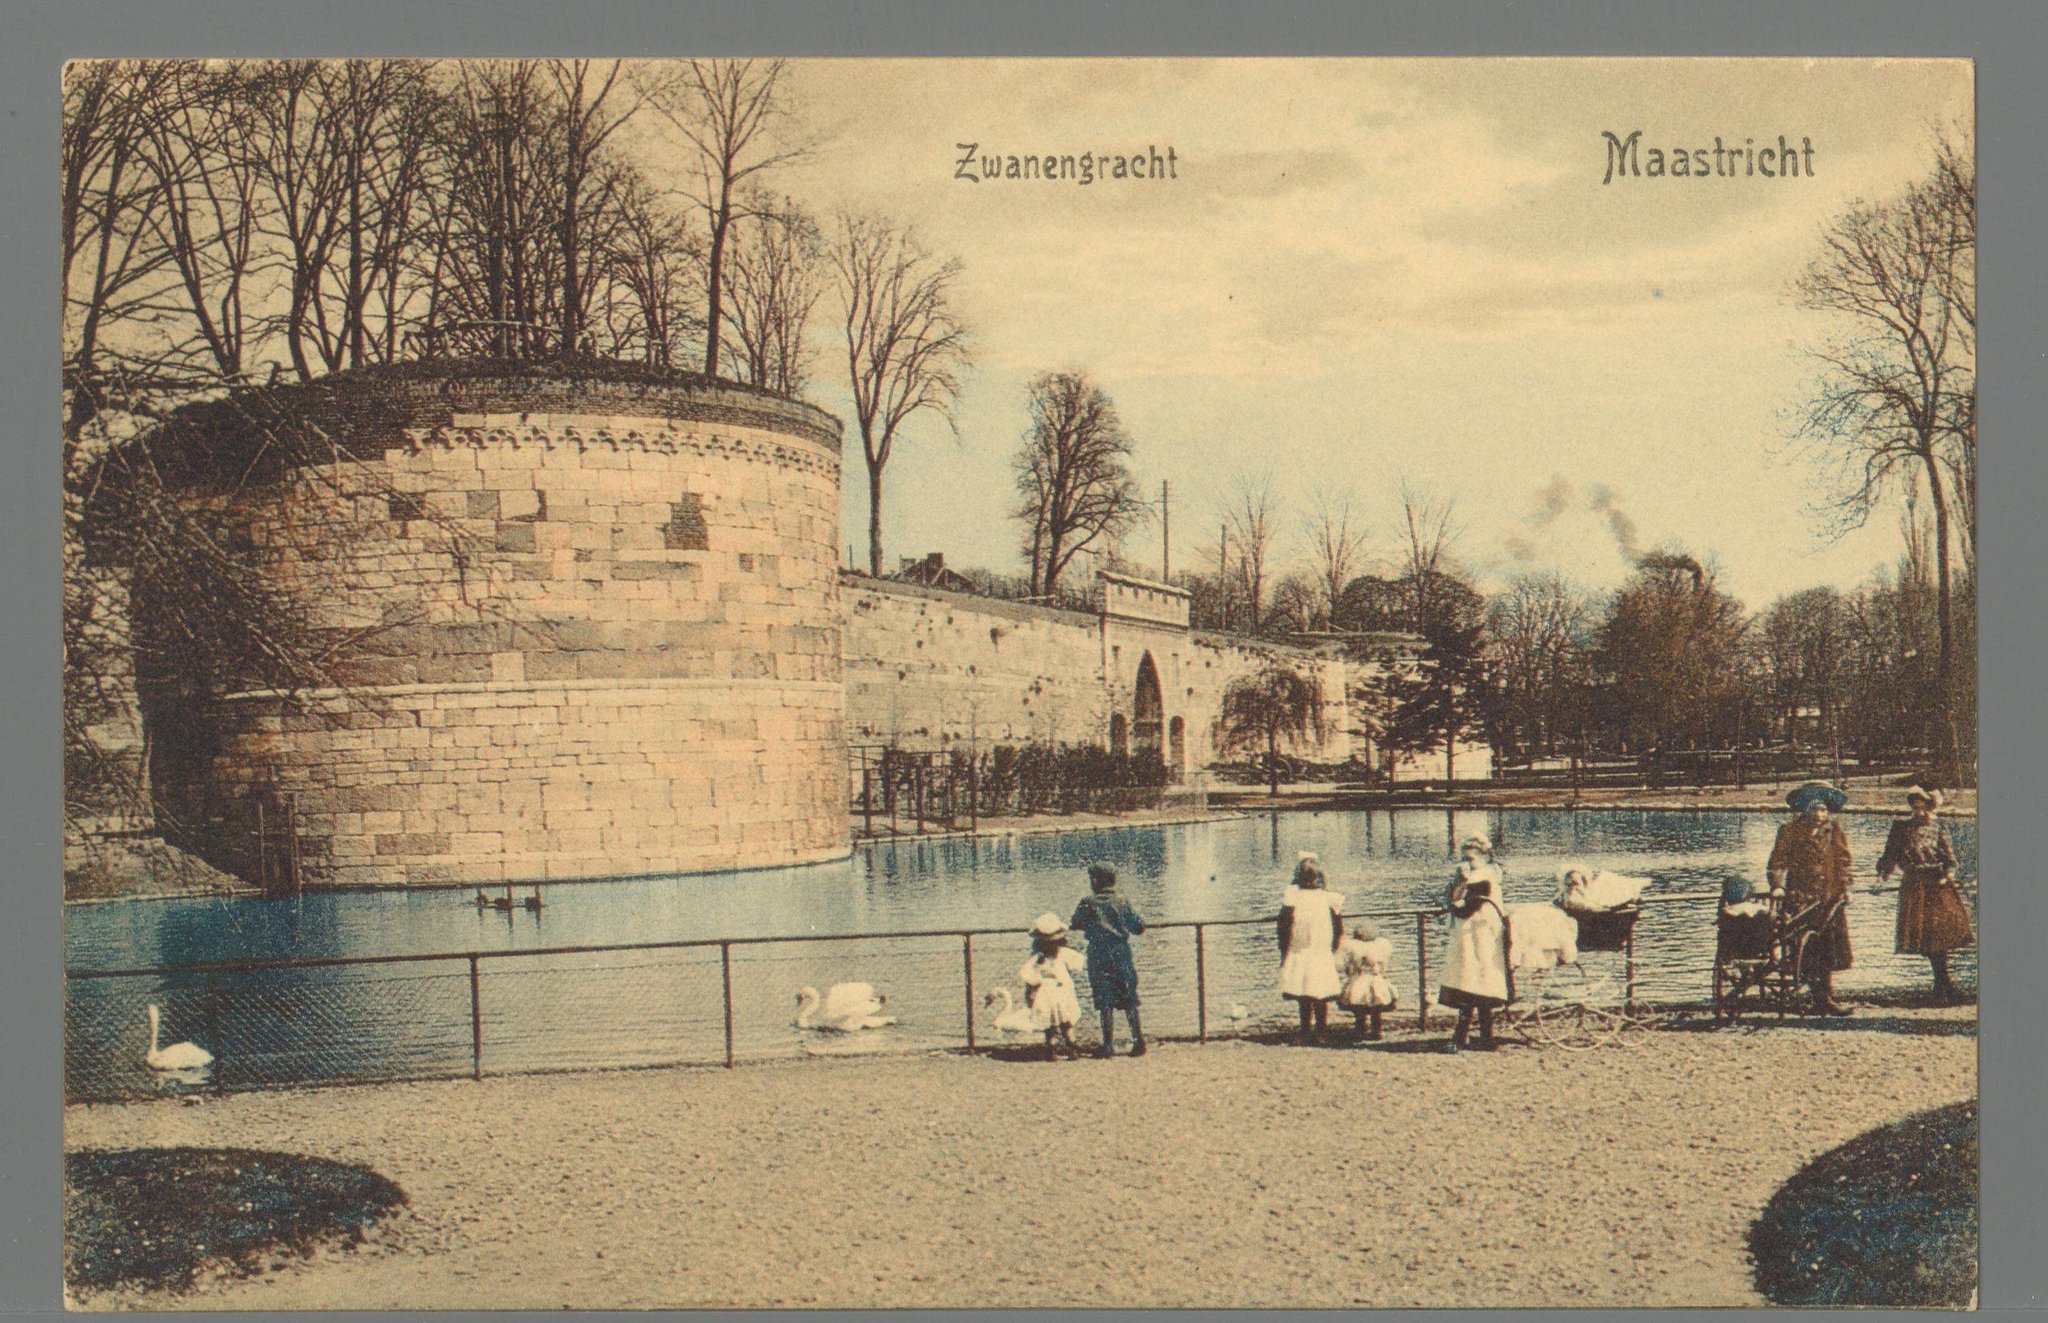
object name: ansichtkaart, prentbriefkaart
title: Zwanengracht. Maastricht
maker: Anonymous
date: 1905-1919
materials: cardboard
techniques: collotype process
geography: maastricht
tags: canal, city-walls, city-gate, maastricht